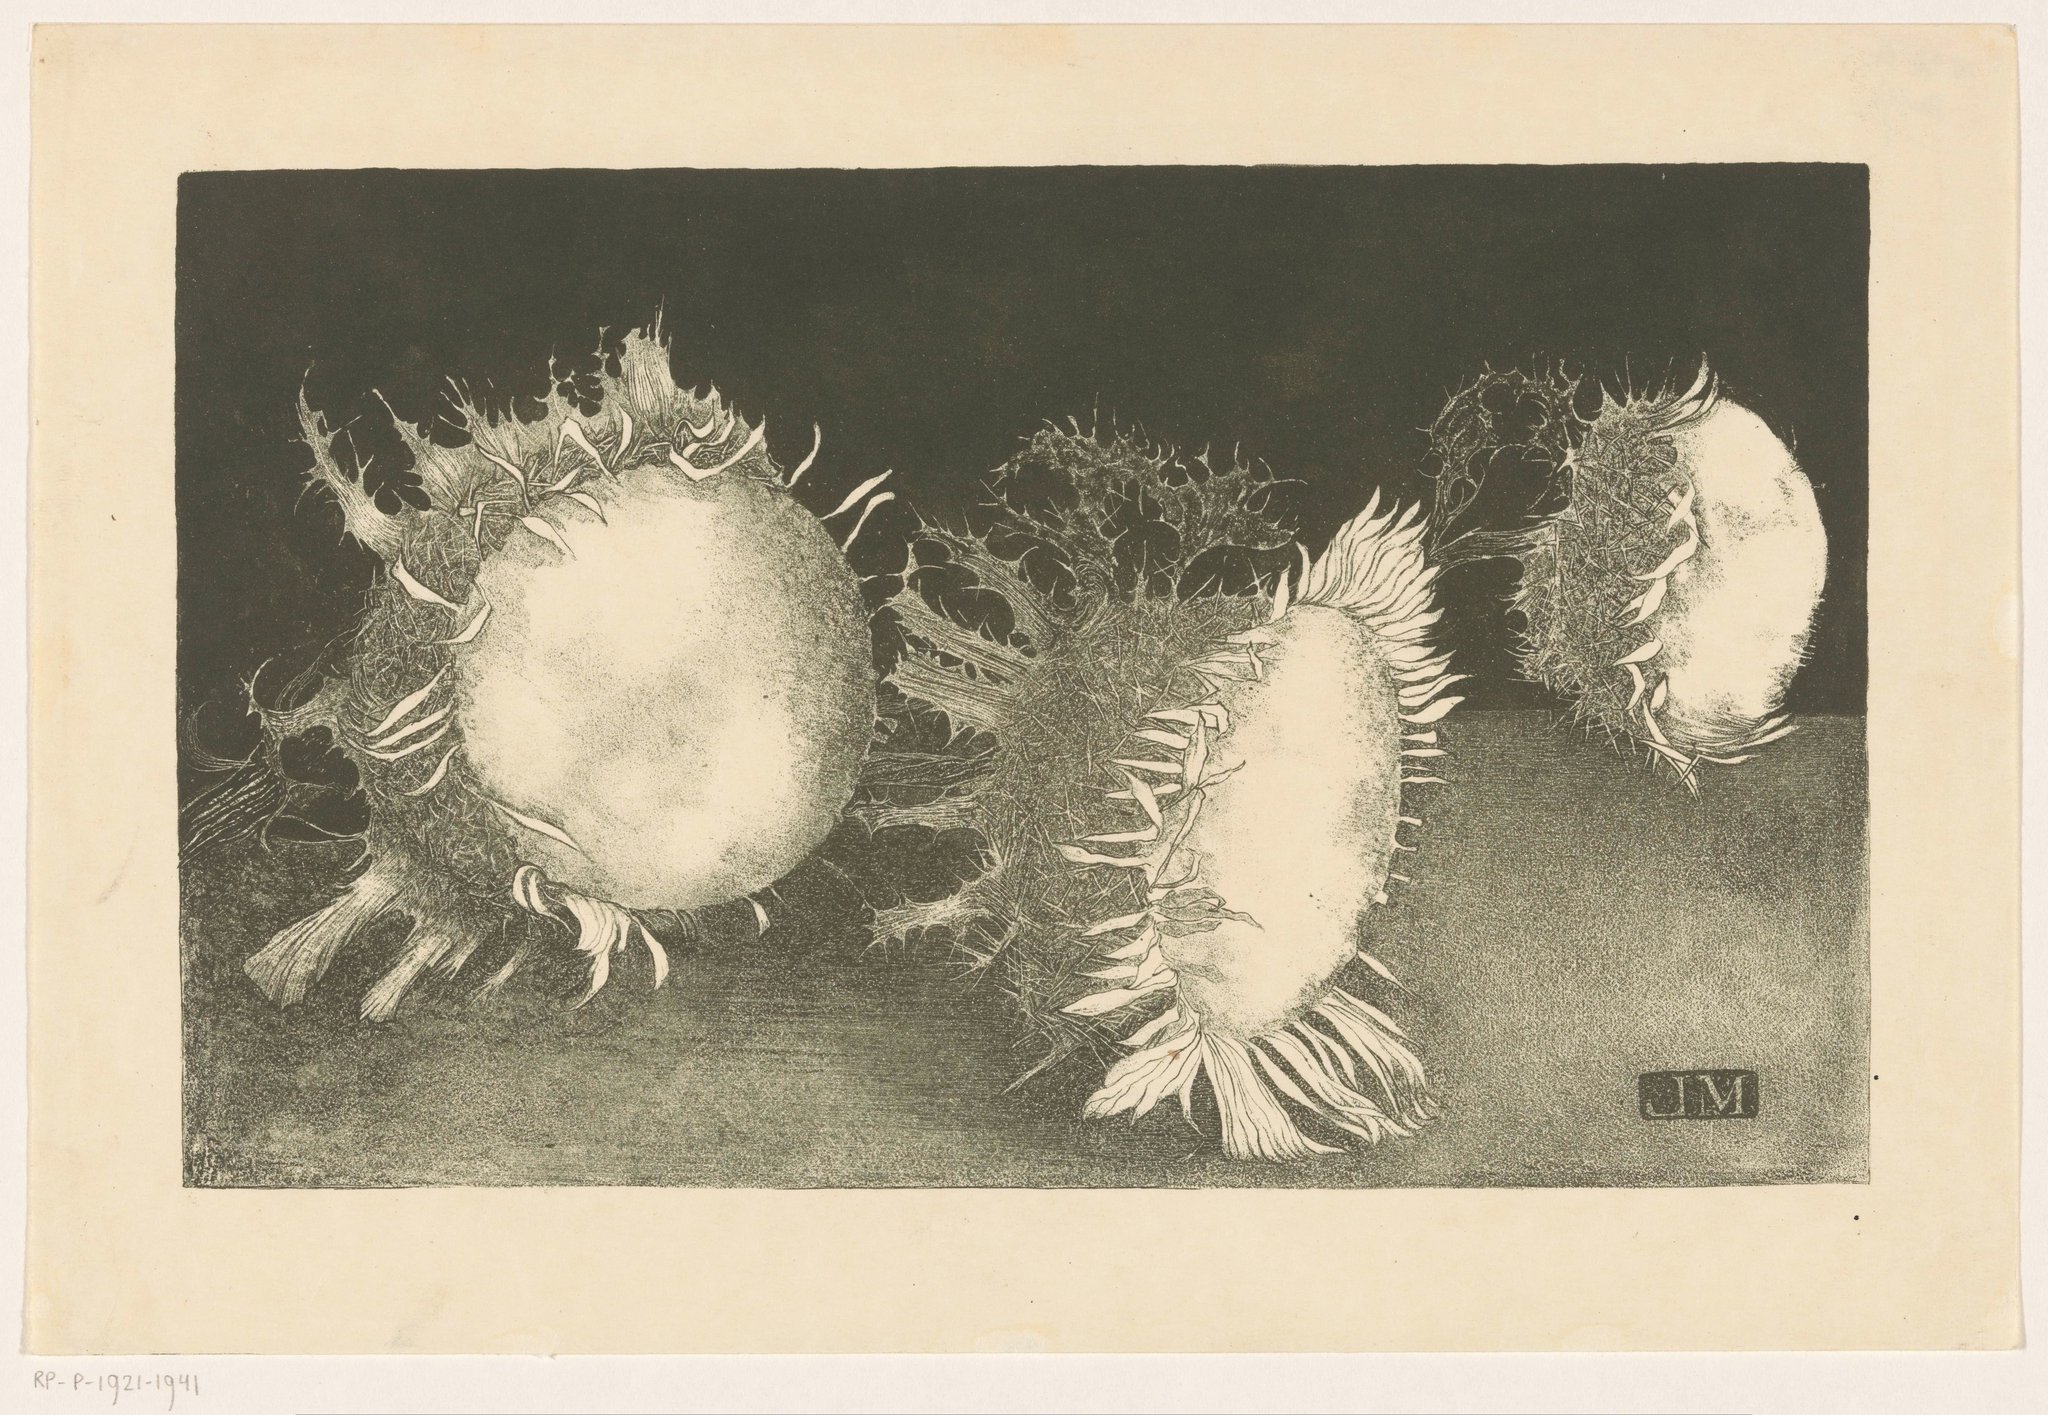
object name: print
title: Drie distelbloemen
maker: jan mankes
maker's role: draughtsman, painter, print maker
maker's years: 1889-1920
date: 1915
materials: paper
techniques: lithograph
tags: plants and herbs: thistle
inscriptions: collector's mark: Lugt 2228